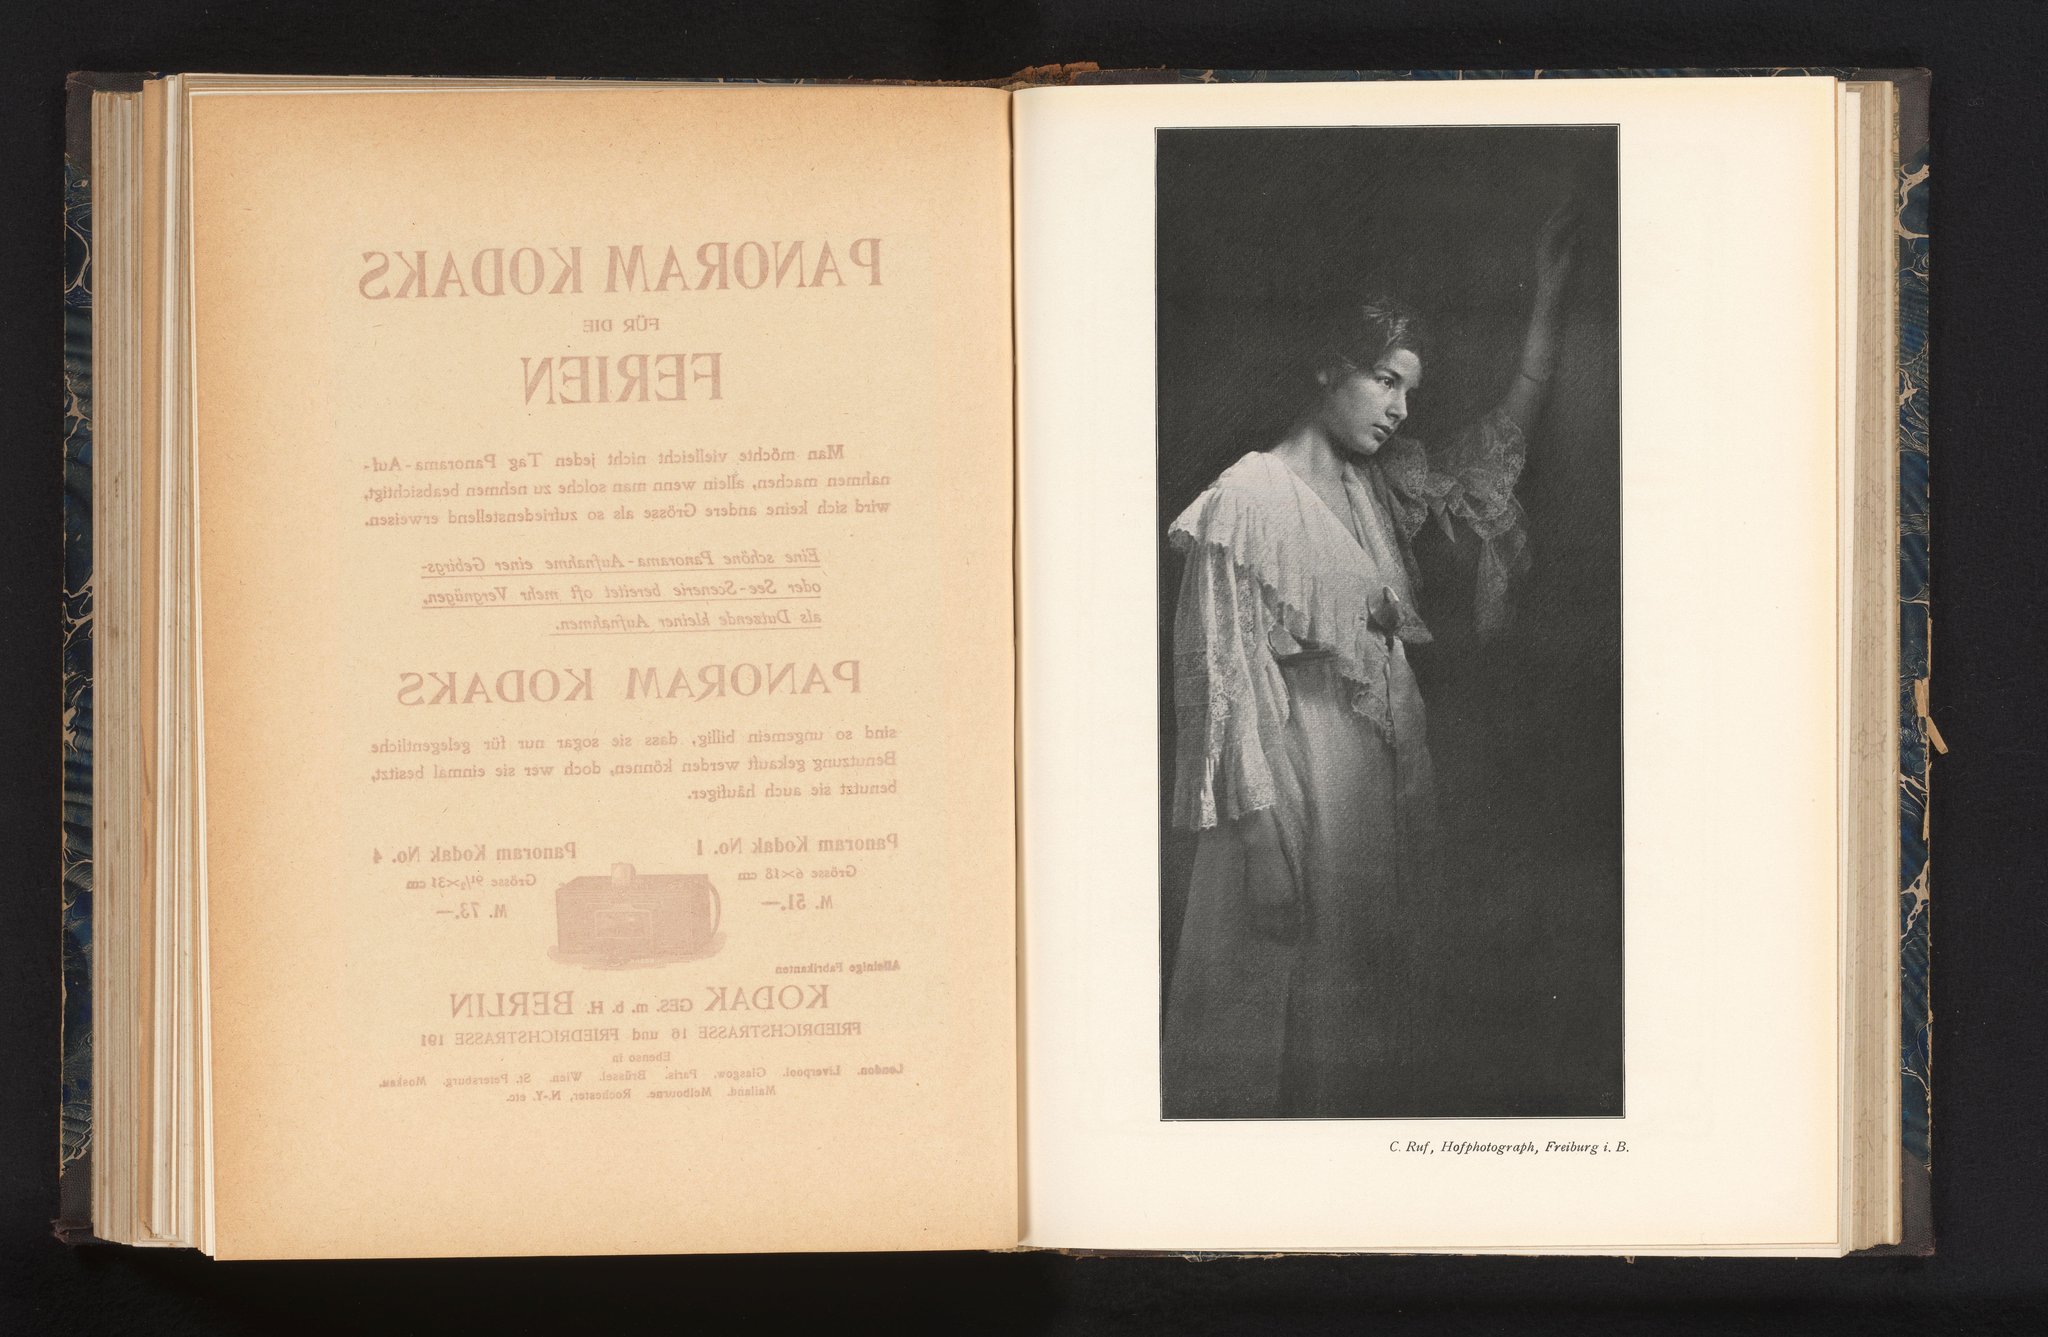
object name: photomechanical print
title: Portret van een onbekende jonge vrouw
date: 1897-1902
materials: paper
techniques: autotype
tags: adolescent, young woman, maiden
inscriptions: monogram: ‘Leipzig/ S.G.’